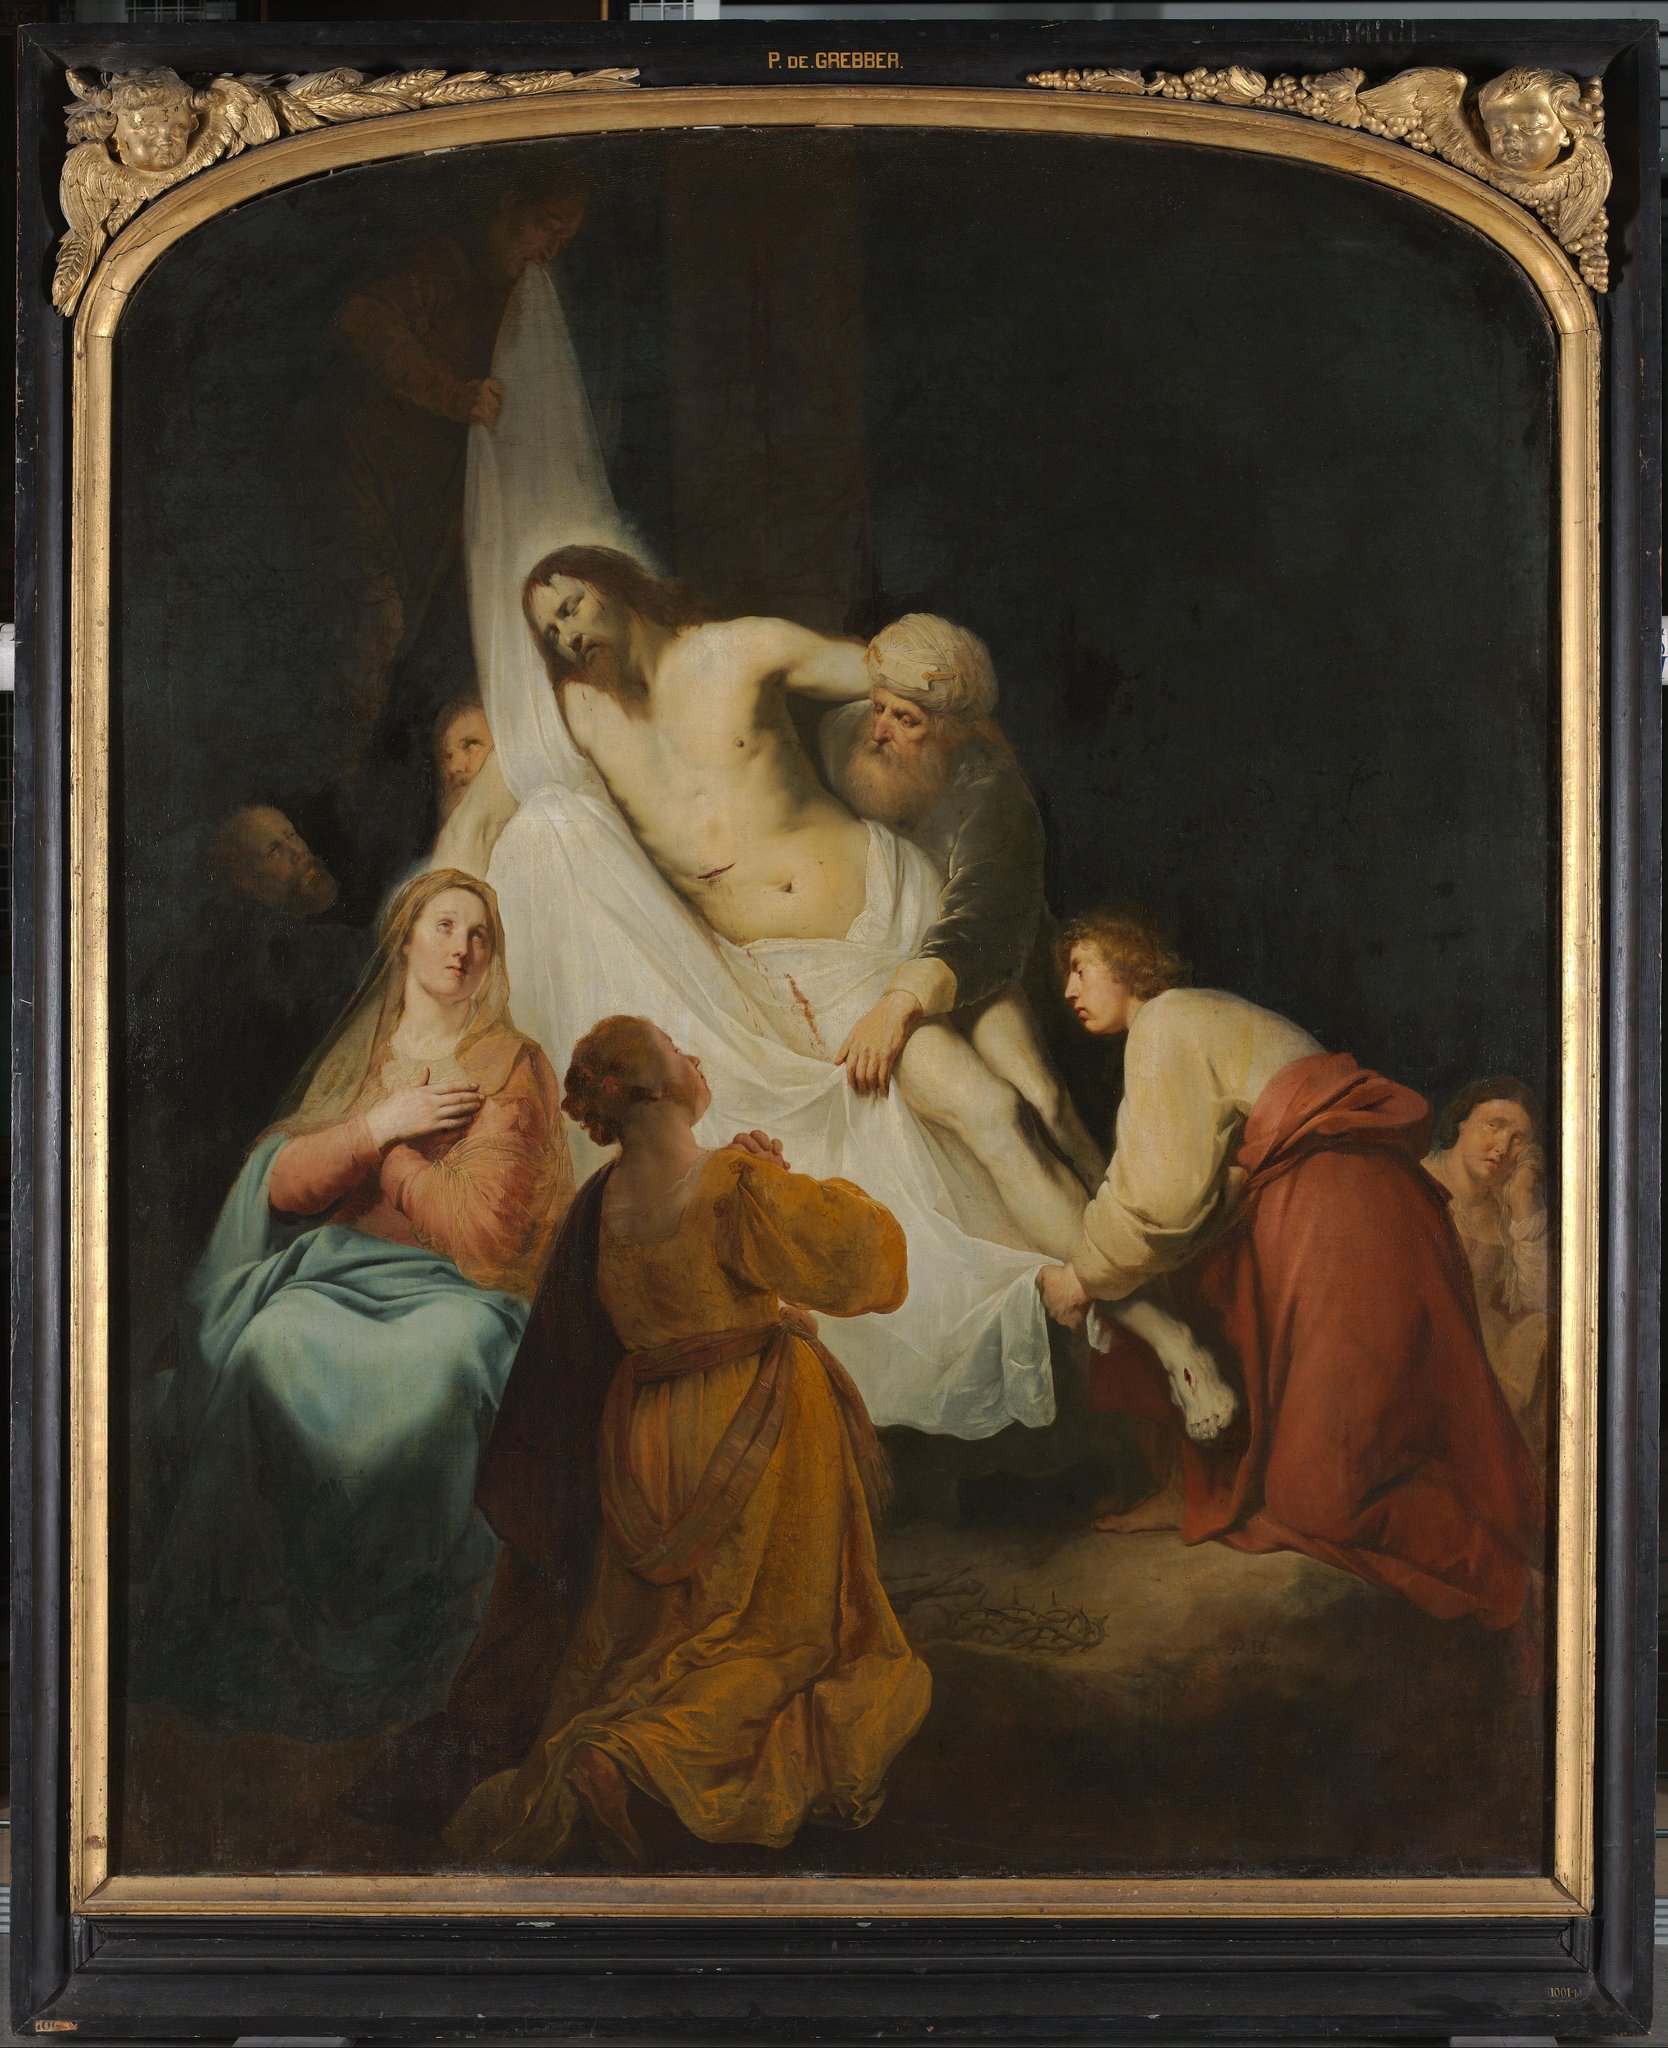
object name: painting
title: The Descent from the Cross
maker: pieter fransz de grebber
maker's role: painter, print maker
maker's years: 1600-1653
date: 1633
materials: canvas, oil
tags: descent from the cross: christ is taken down from the cross, usually by nicodemus and joseph of arimathaea who are standing on the ladders (both arms of christ detached)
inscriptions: signature and date: ‘P. DG Aº 1633’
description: Pieter Fransz. de Grebber (c. 1600 - c. 1653).The Descent from the Cross, 1633. The Haarlem-born Catholic painter Pieter de Grebber made this altarpiece in 1633 for the Church of St Gommarus and St Pancras in the Breedstraat in Enkhuizen. Pieter de Grebber was related by marriage to Augustinus de Wolff - pastor of the parish and the man who commissioned the work: De Wolff's brother was married to the artist's sister Maria Fransdr. de Grebber, who was herself a painter. She had painted a portrait of her brother-in-law in 1631. The painting is shown here in its original frame. The work is not in the best of conditions - the varnish has yellowed and become opaque. Purchased from H.J. Dierenbach, pastor of the Old Catholic Church in Enkhuizen, 1907.